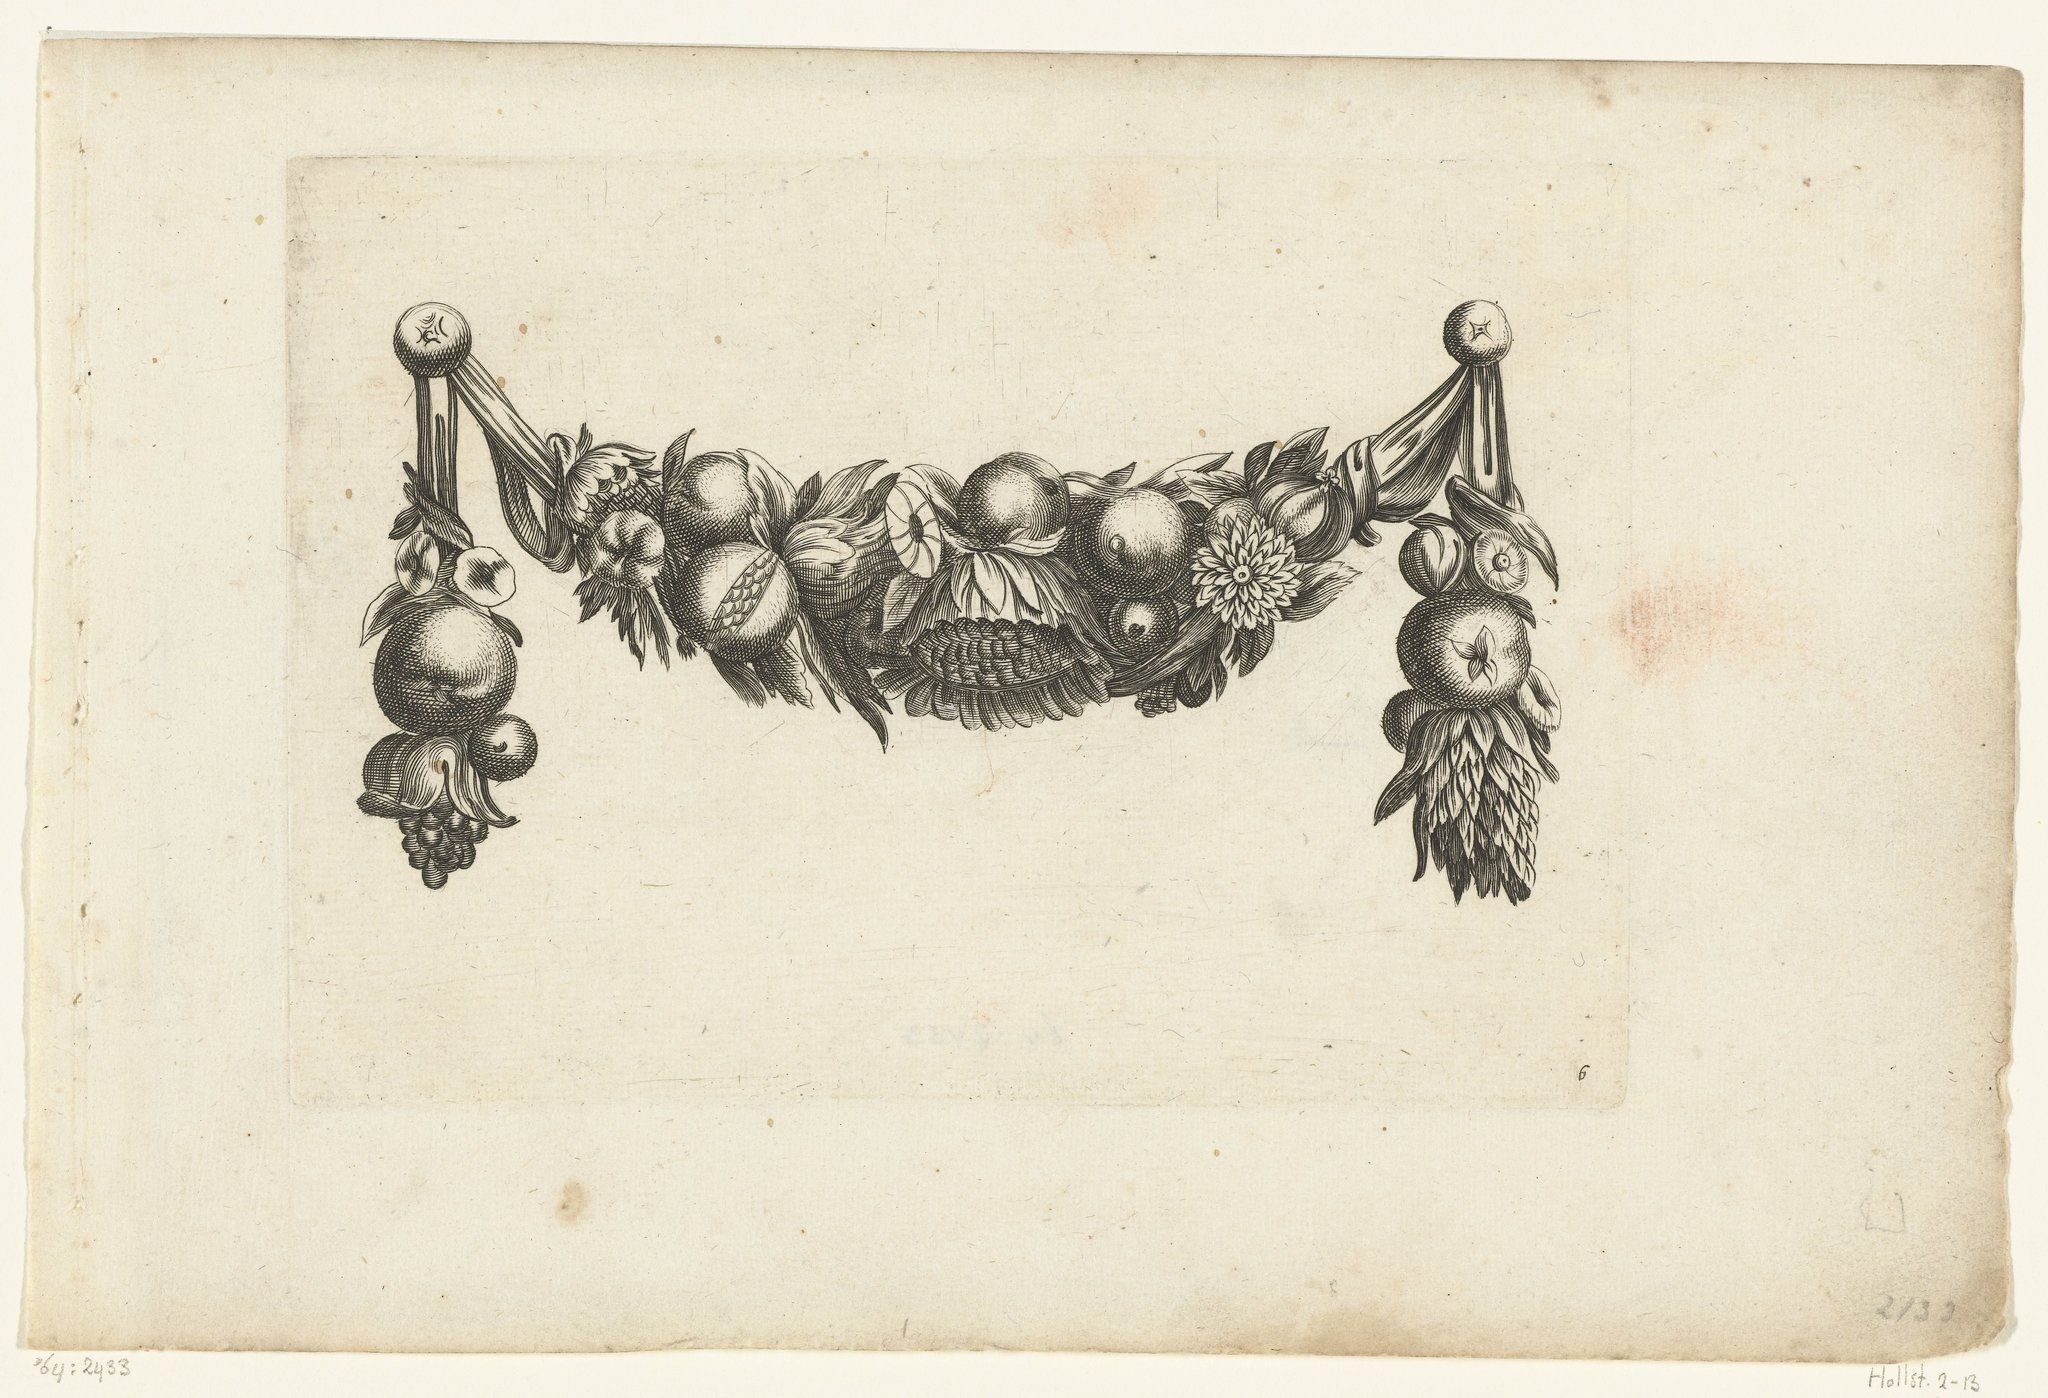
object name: print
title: Festoen met een grote bloem in het midden die naar beneden hangt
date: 1655-1678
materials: paper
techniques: engraving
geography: amsterdam